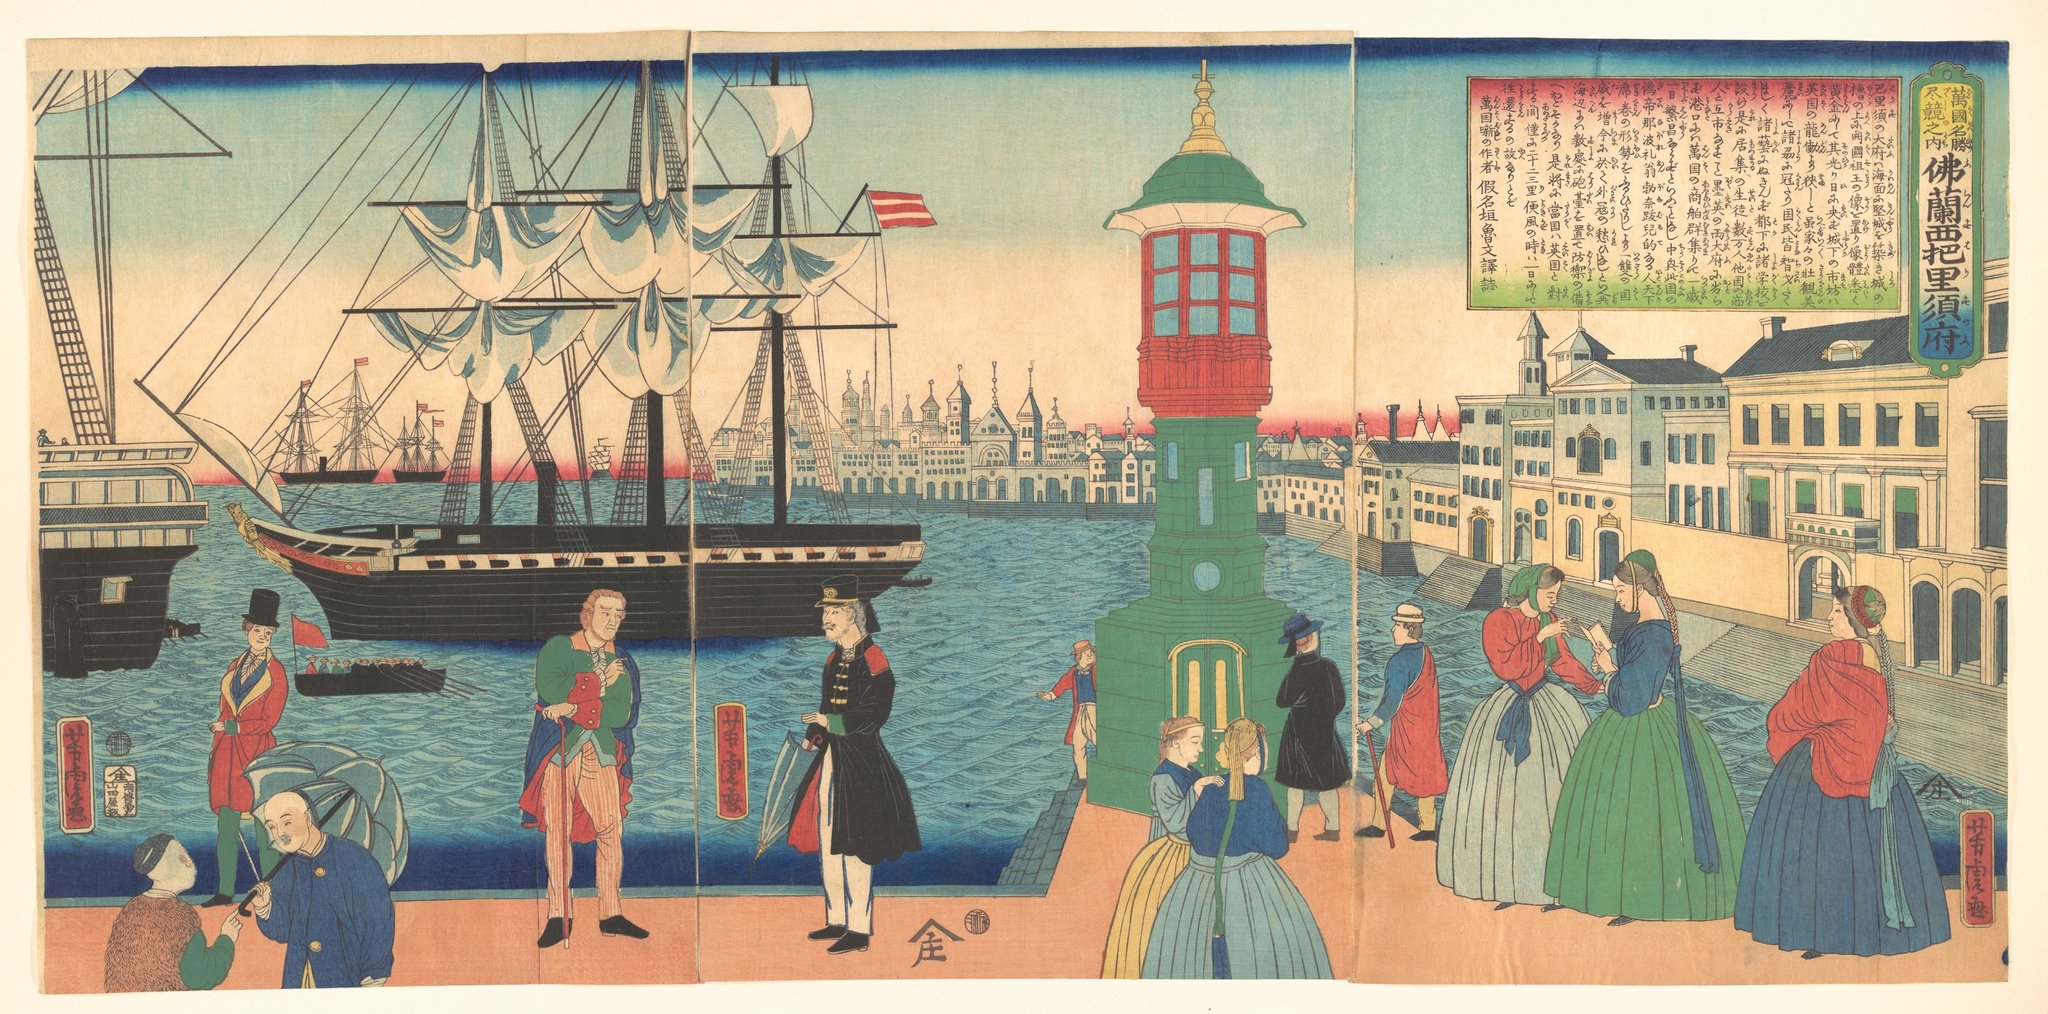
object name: print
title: Paris, France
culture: japanese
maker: utagawa yoshitora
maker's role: artist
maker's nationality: japanese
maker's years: 1845-1880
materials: ink, paper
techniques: woodblock print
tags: men,women,ships,paris